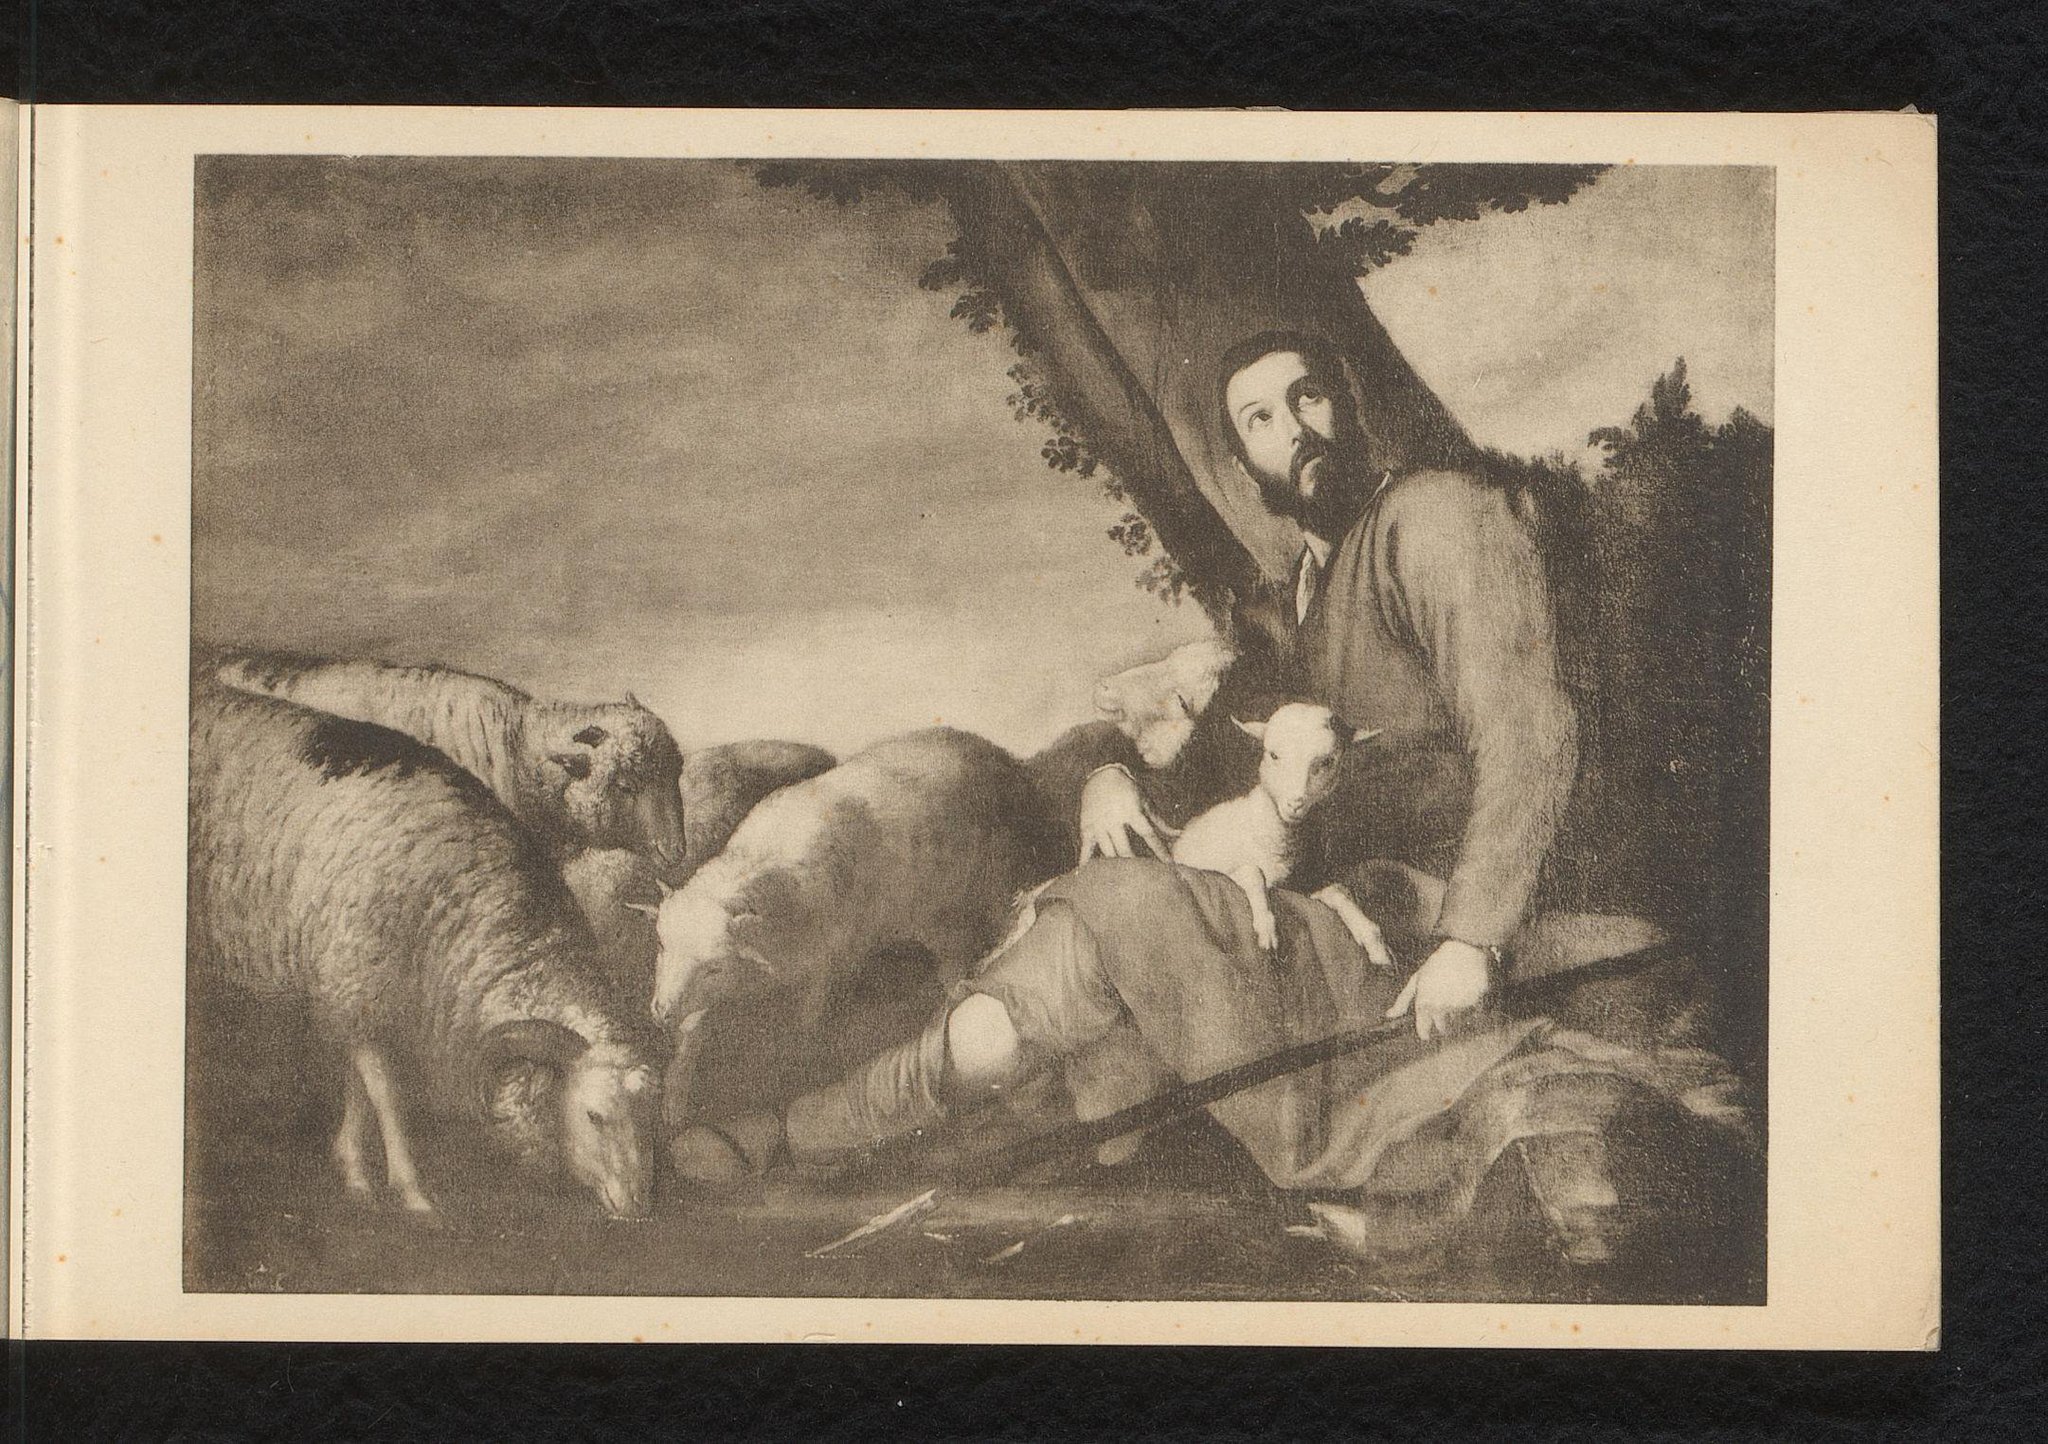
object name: reproduction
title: Museo Cerralbo. Madrid. El Divino Pastor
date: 1924-1930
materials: cardboard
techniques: photograph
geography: madrid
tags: permanent exhibition, museum, picture, painting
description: Prentbriefkaart maakt deel uit van een album.